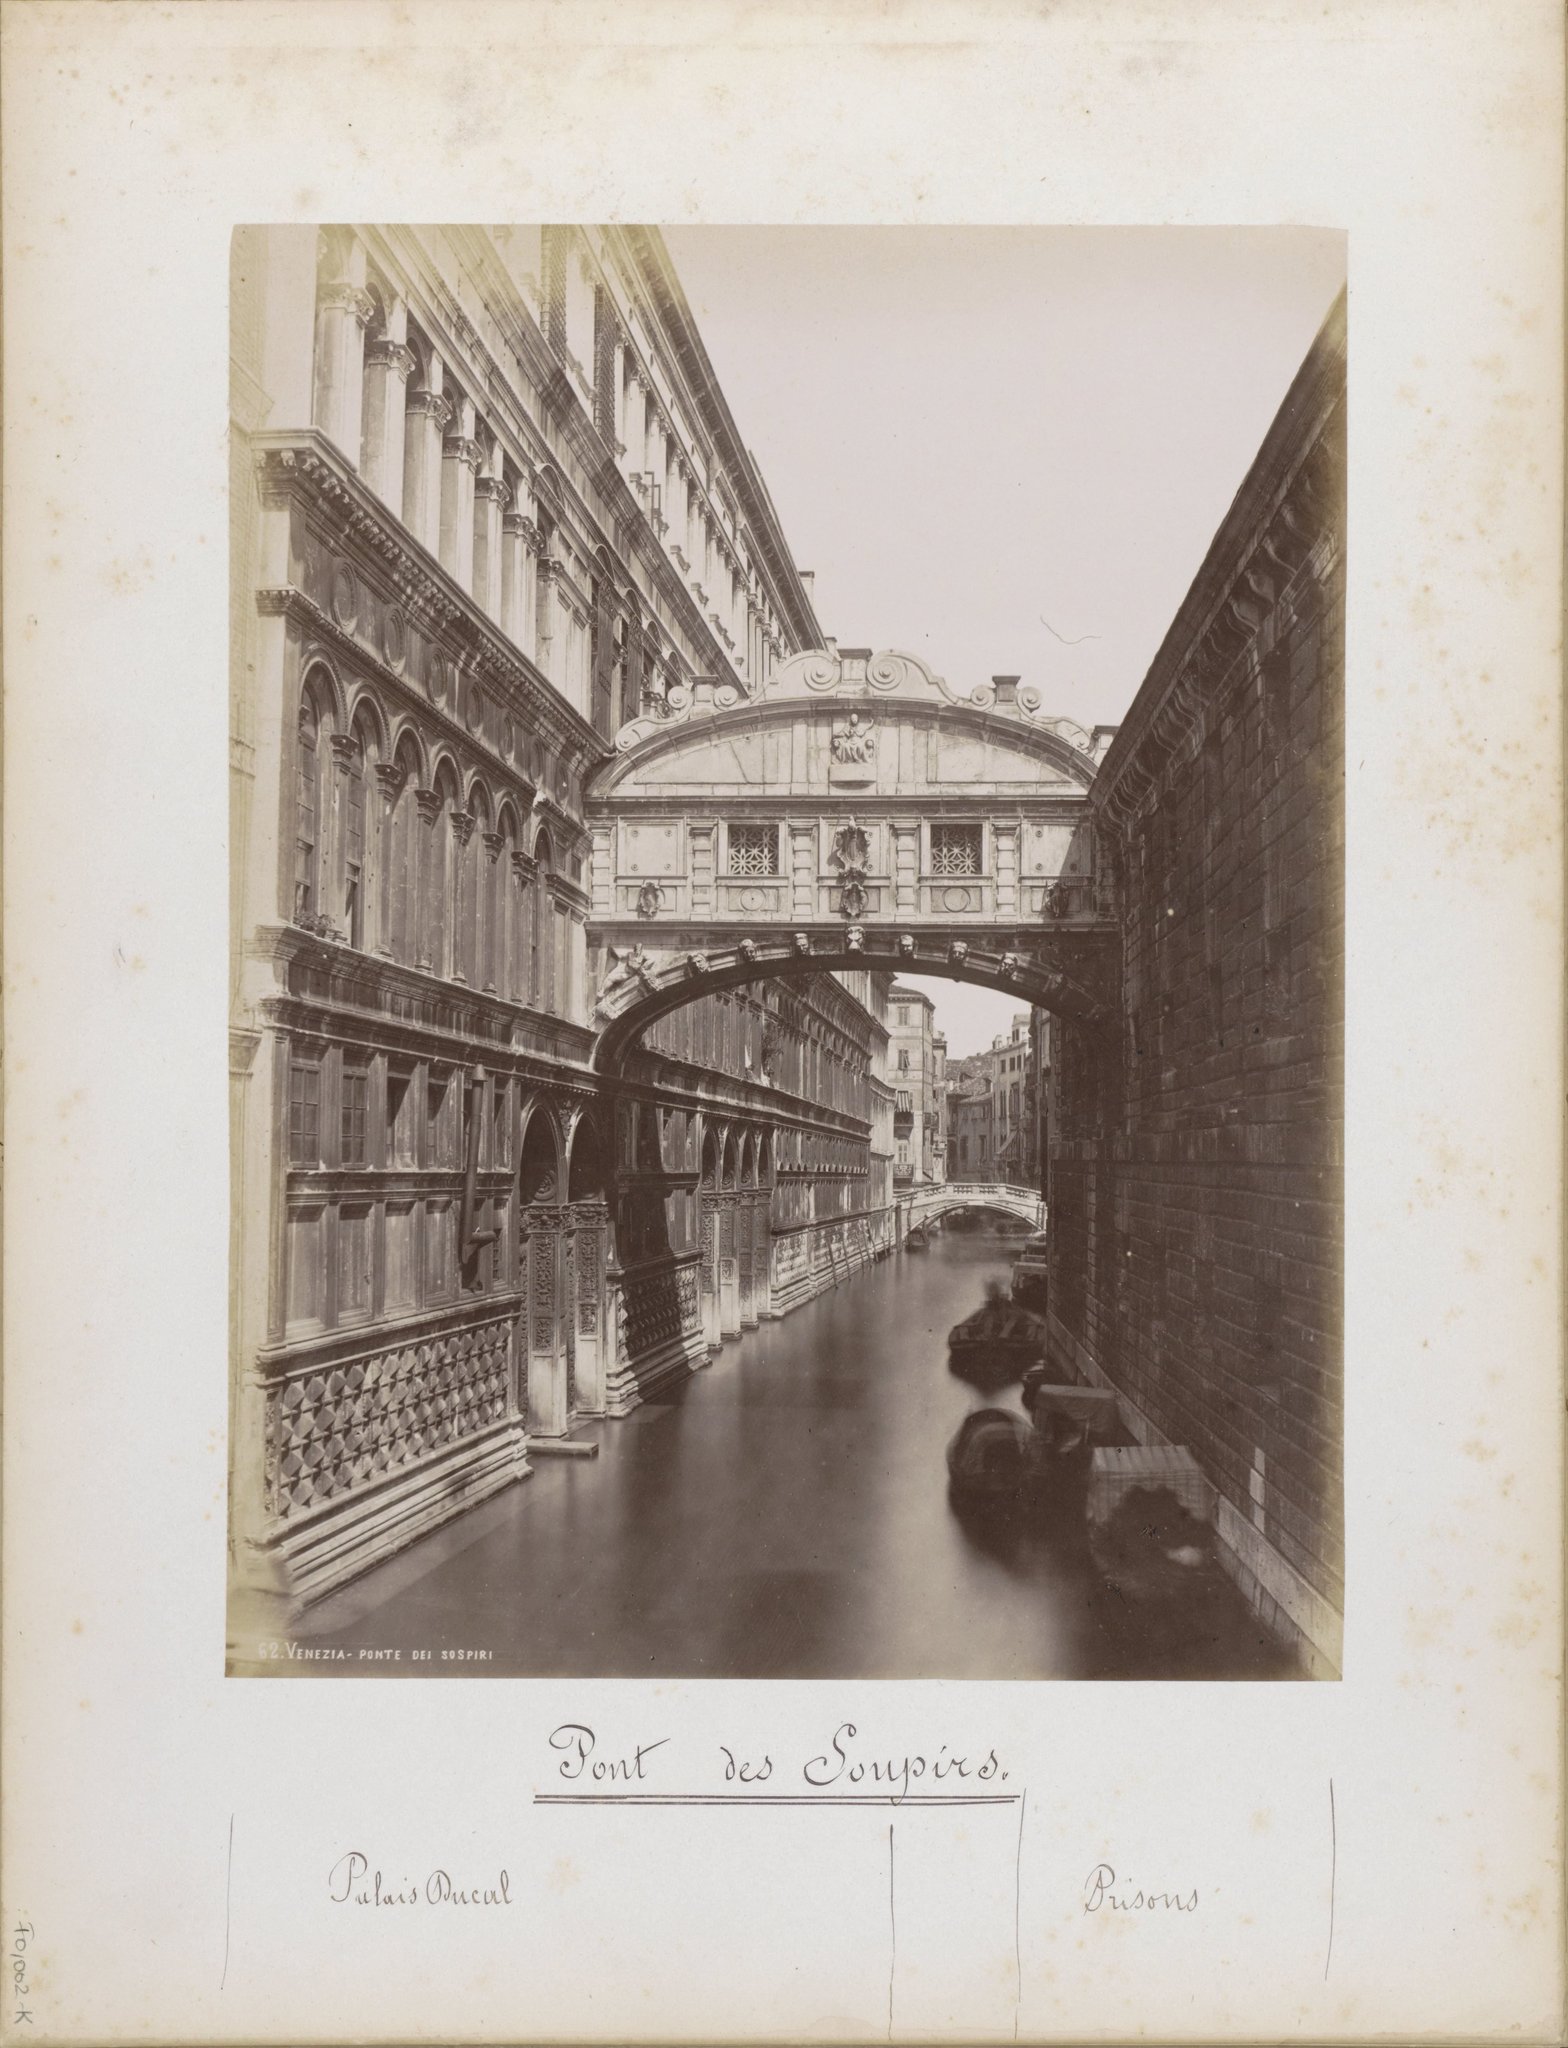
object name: photograph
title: Venezia - Ponte dei Sospiri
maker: carlo ponti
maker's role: fotograaf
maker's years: 1820-1893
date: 1860-1881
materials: photographic support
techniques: albumen print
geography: venice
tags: prison, jail, palace, bridge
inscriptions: check stamp: ‘Carlo Ponti Venezia’, negative number: ‘62’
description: Onderdeel van Topografisch album van Venetië 1881.